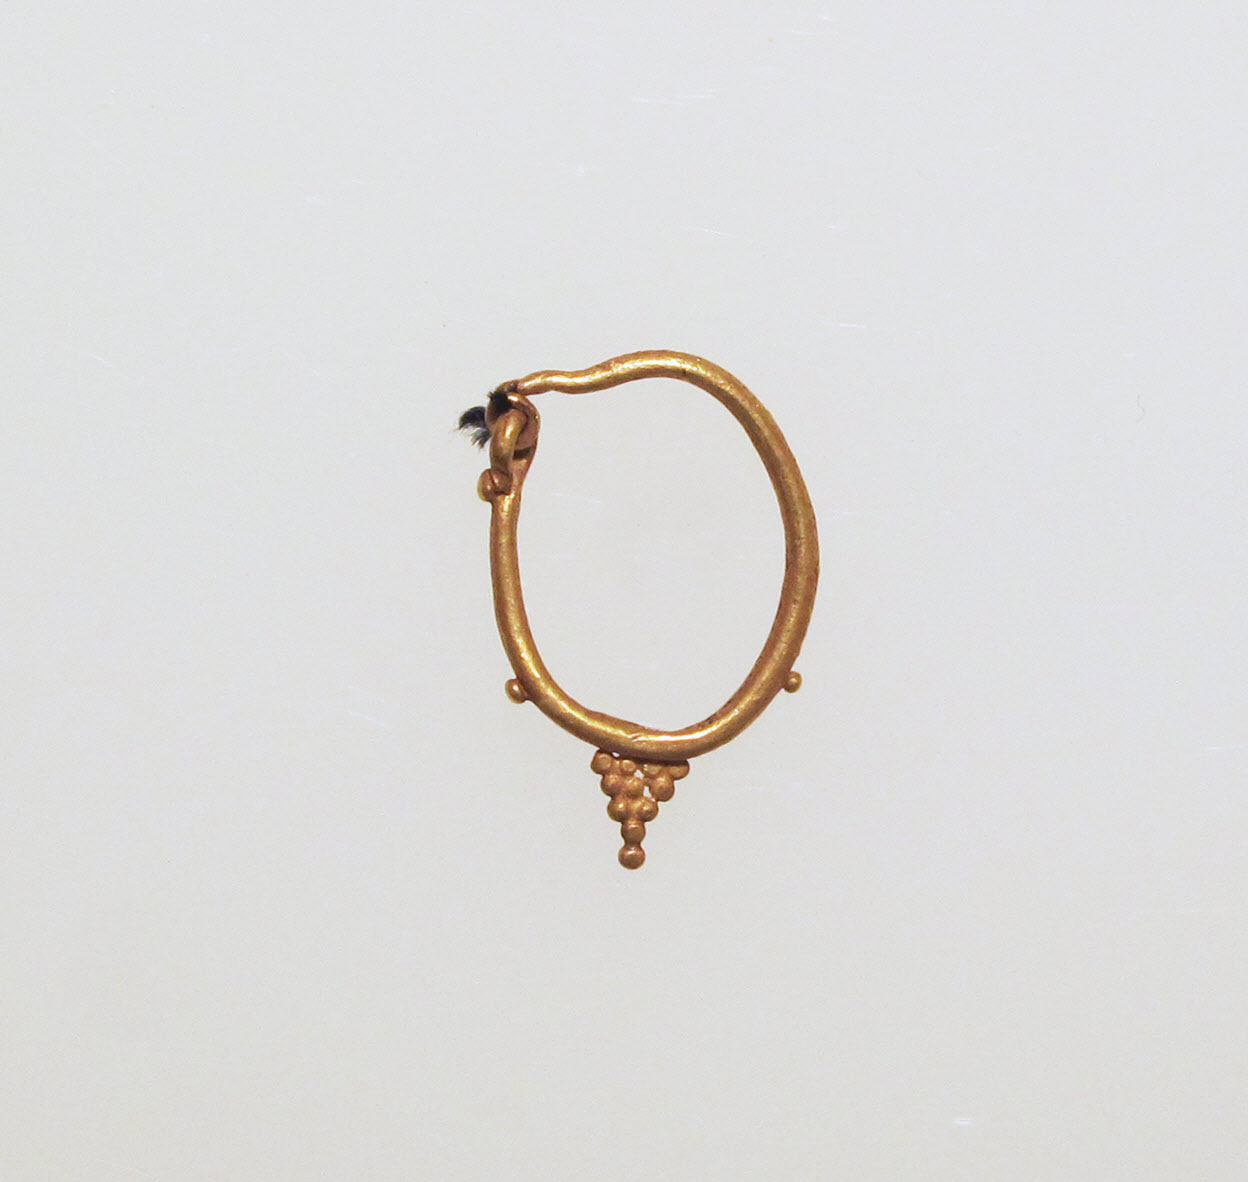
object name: earring with pyramid of ball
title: Earring with pyramid of balls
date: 7000 BCE-330 CE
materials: gold